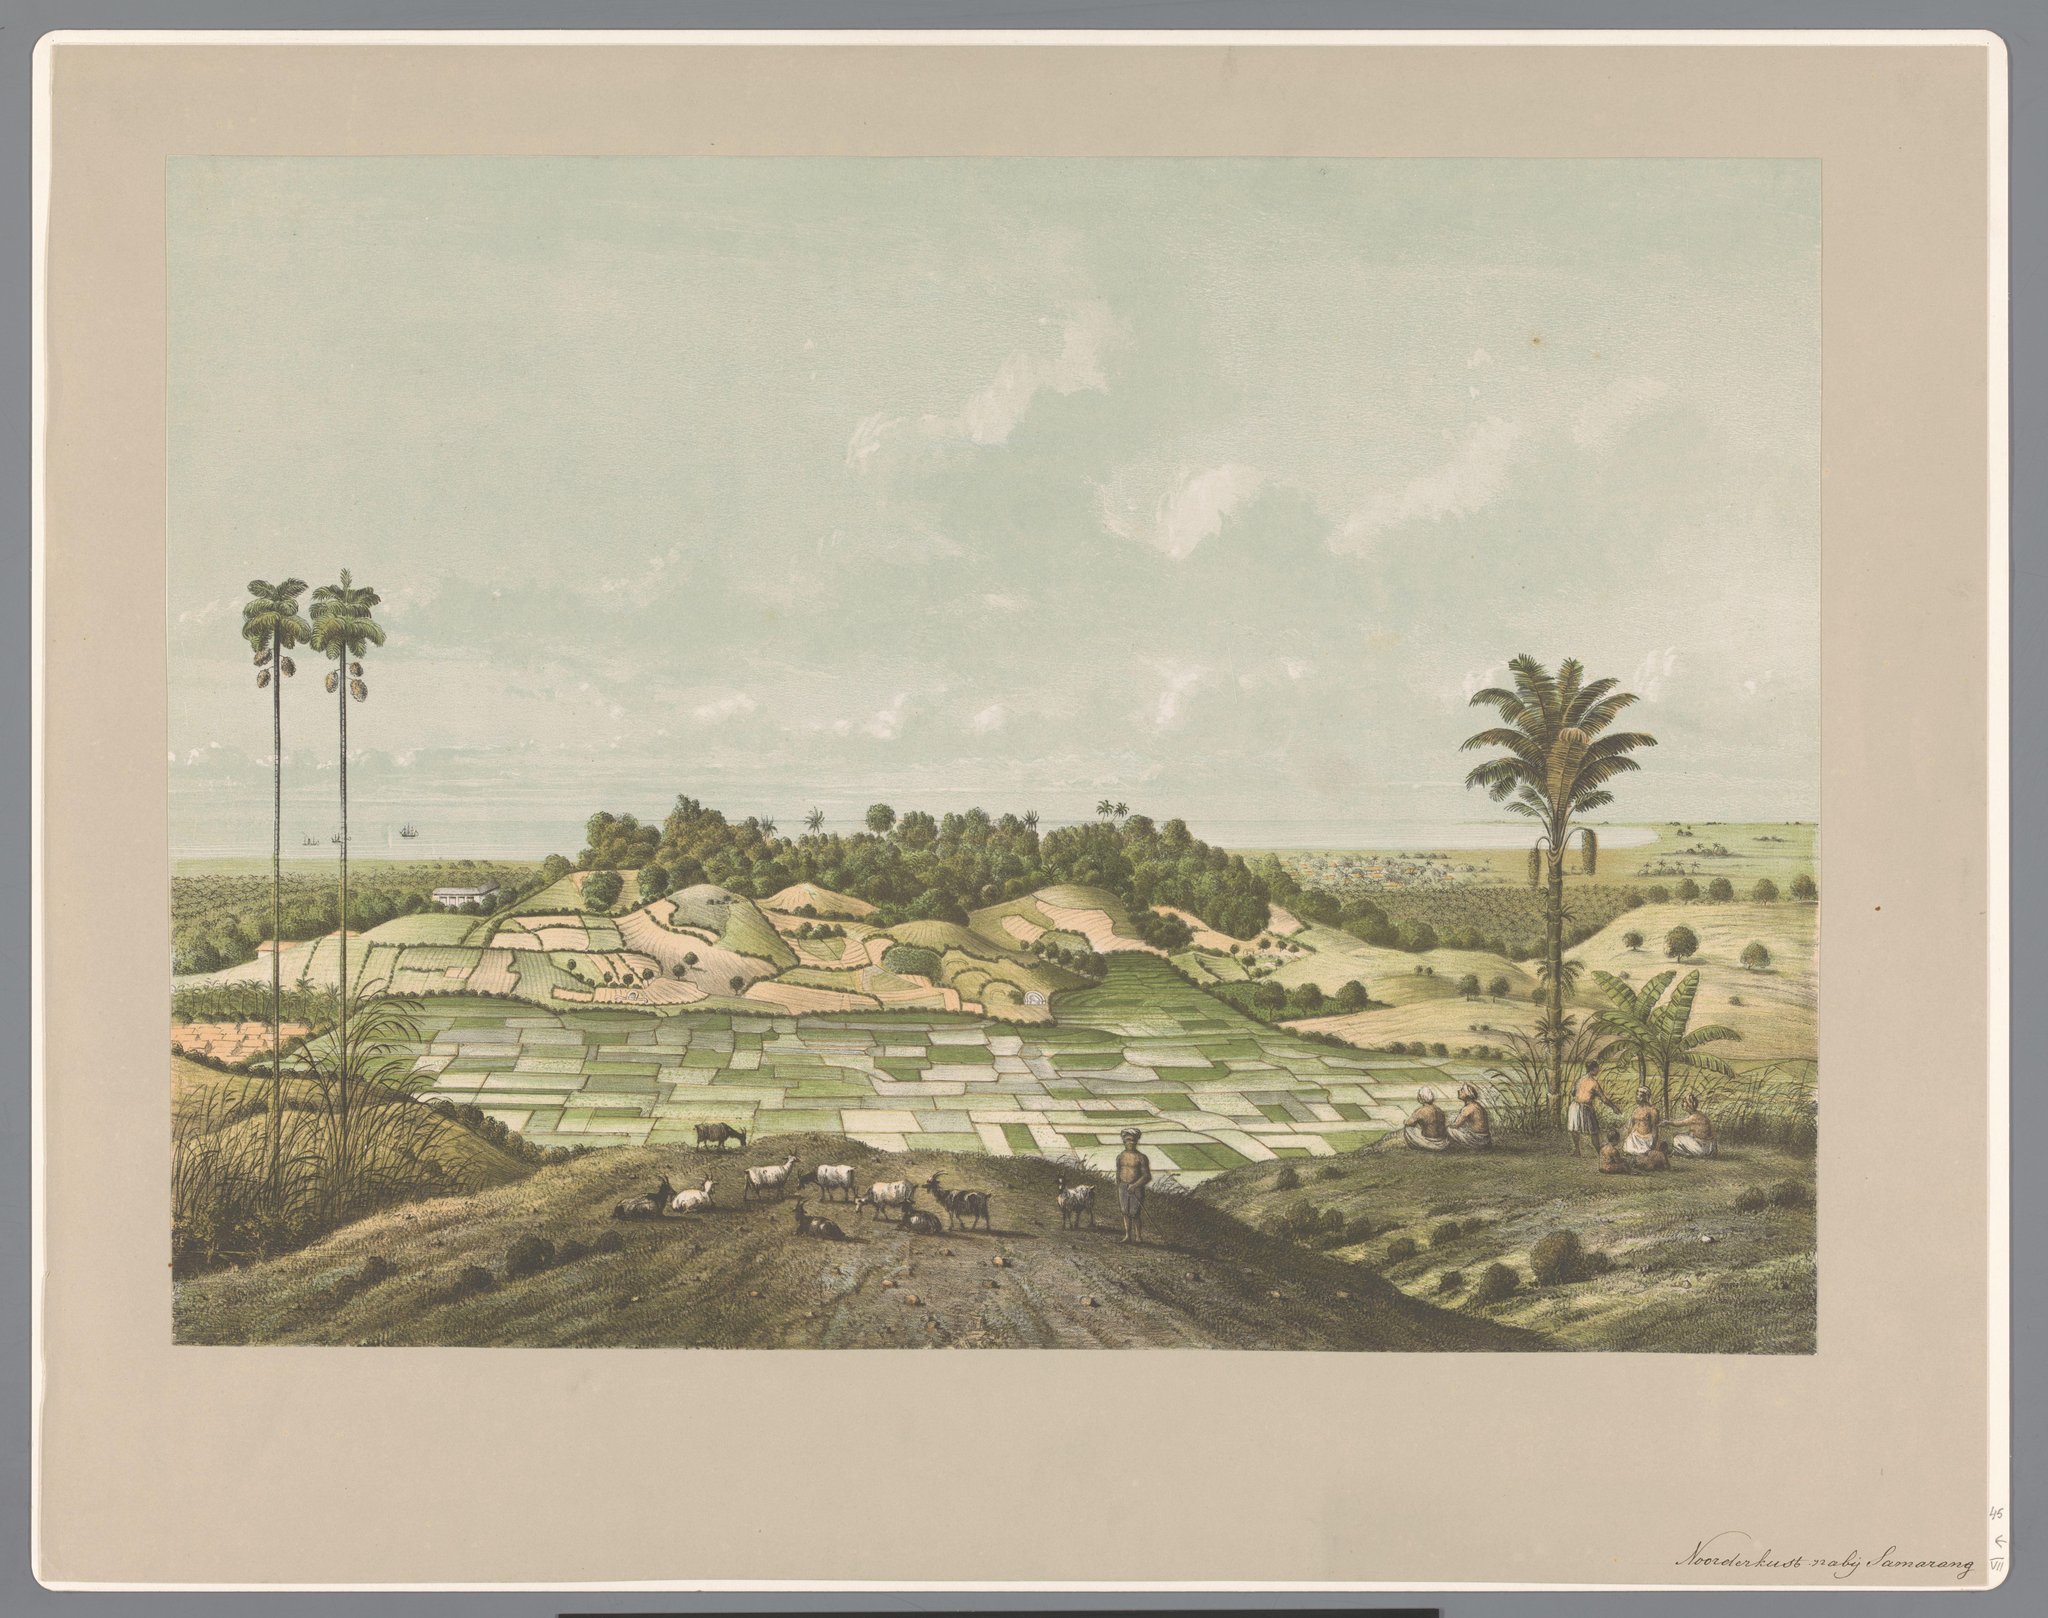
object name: print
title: Noordkust nabij Semarang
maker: carl wilhelm mieling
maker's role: print maker, printer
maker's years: 1815-1903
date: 1853-1854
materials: cardboard, paper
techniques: lithograph, hand coloring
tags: beach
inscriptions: collector's mark: Lugt 2228, collector's mark: Lugt 2228, annotation: ‘Noorderkust nabij Samarang’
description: Prent uit: Junghuhn, Franz Wilhelm. Atlas van platen, bevattende elf pittoreske gezigten: behoorende tot het werk Java, zijne gedaante, zijn plantentooi en inwendige bouw. Amsterdam: s.n., 1854. Of: Junghuhn, Franz Wilhelm. Elf Landschafts-Ansichten von Java. Leipzig: Arnold, 1853.